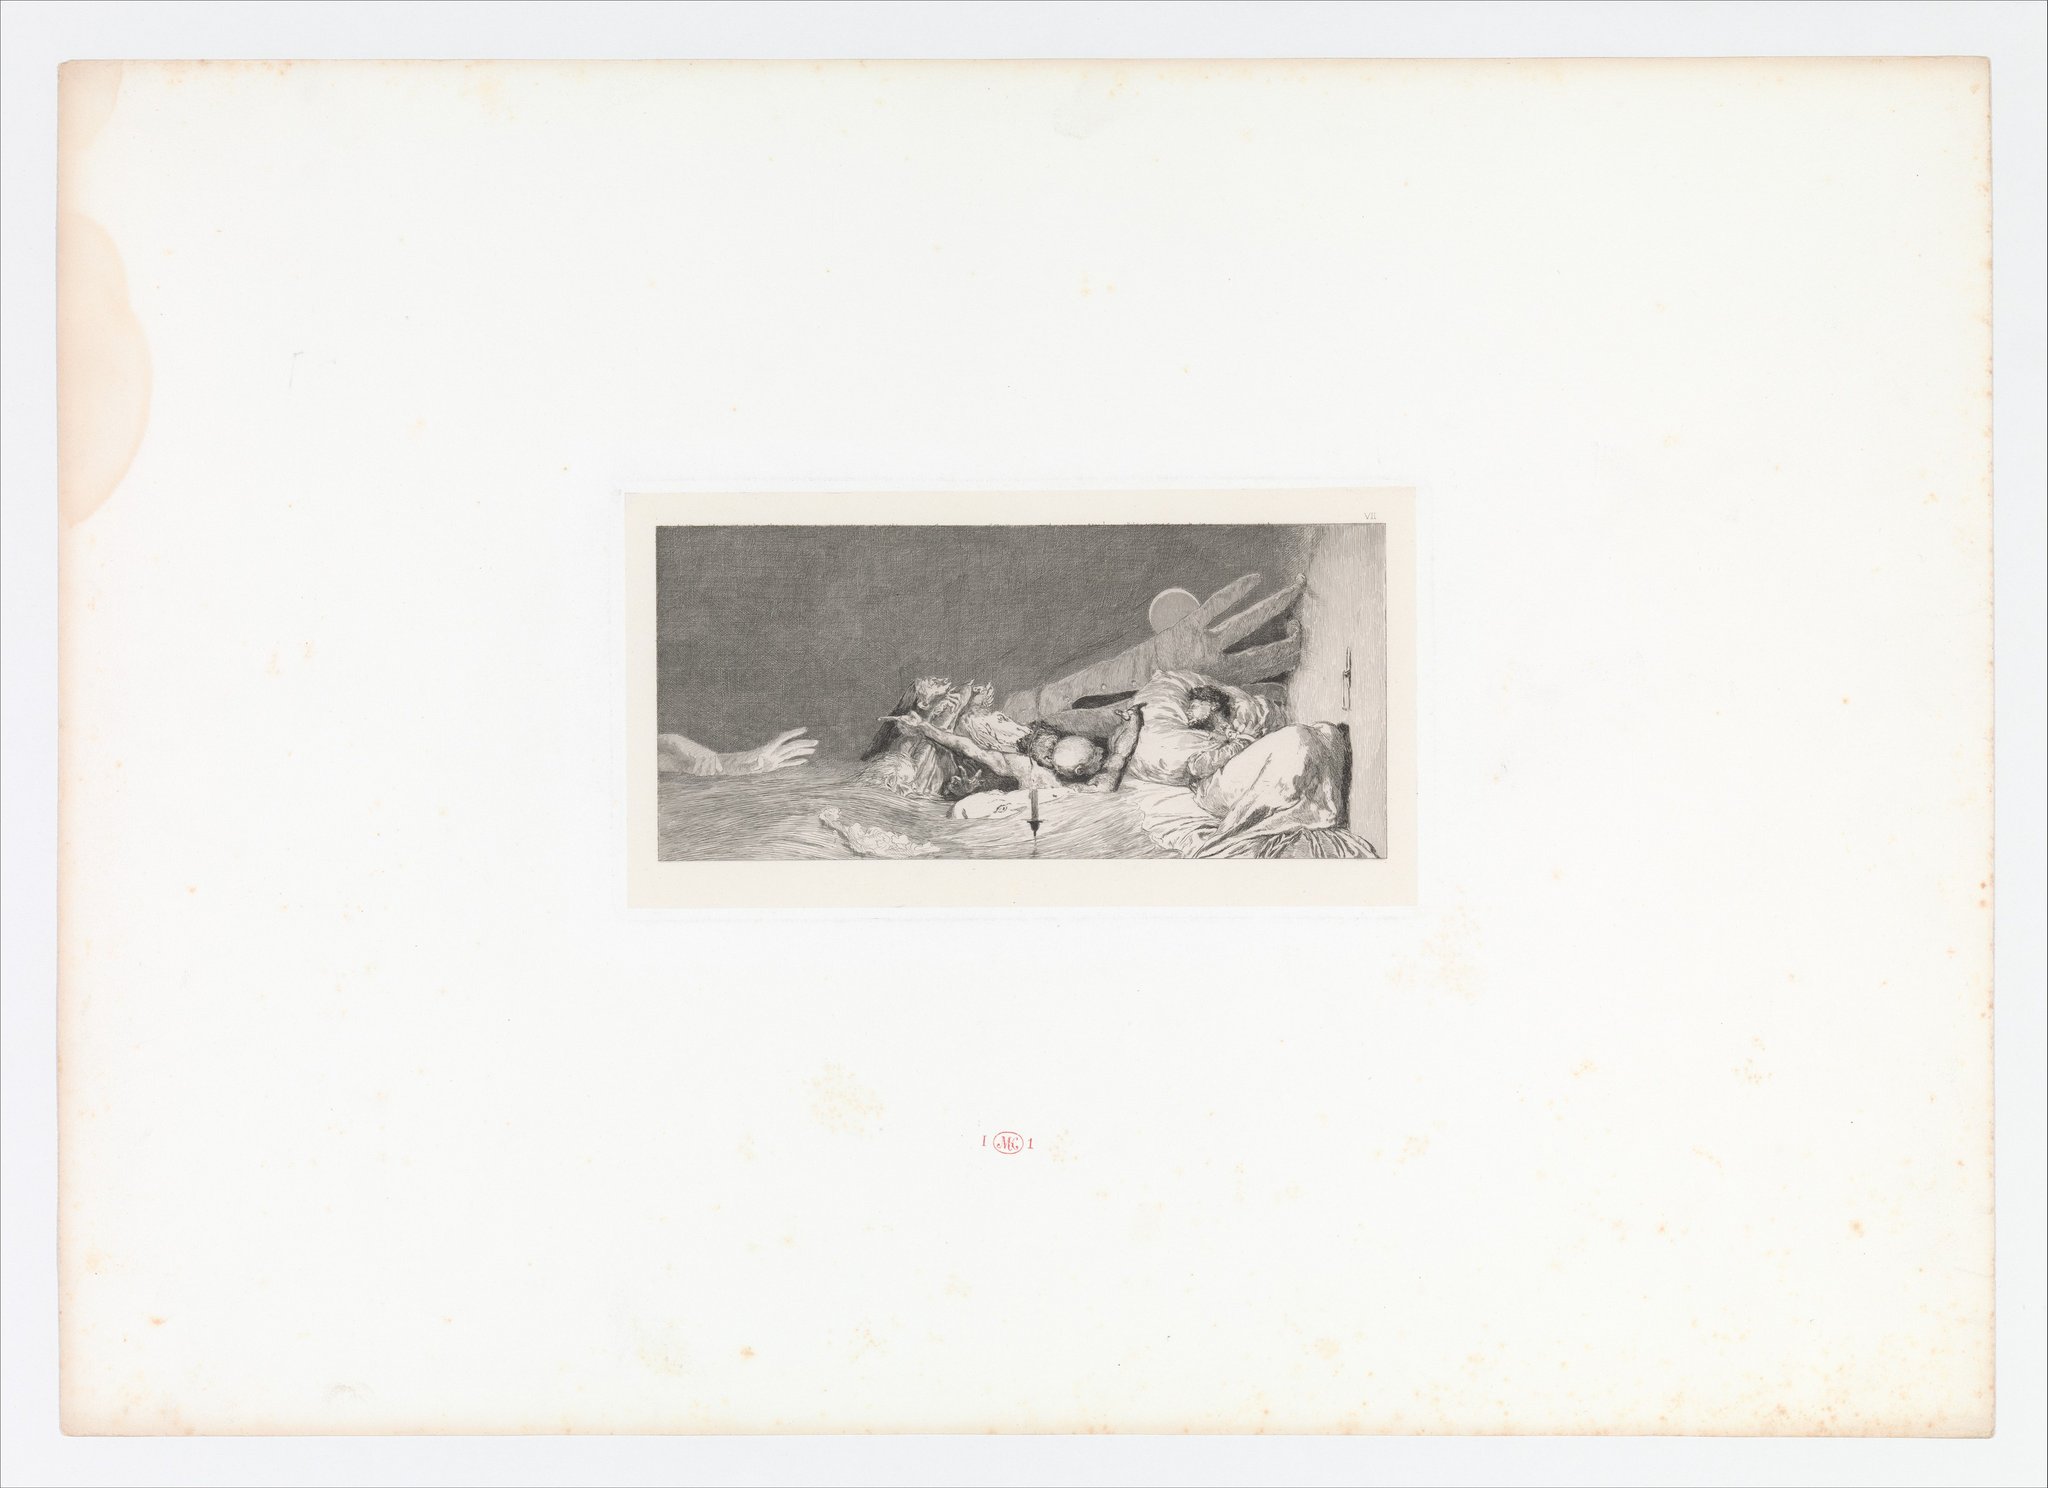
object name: print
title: Ängste (Fears) from Ein Handschuh (A Glove). Cyclus von zehn Compositionen radirt. Rad. Opus VI, Plate VII. First edition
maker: max klinger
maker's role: artist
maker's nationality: german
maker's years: 1857-1920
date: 1881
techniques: aquatint, printmaking, drypoint, etching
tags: human figures,fear